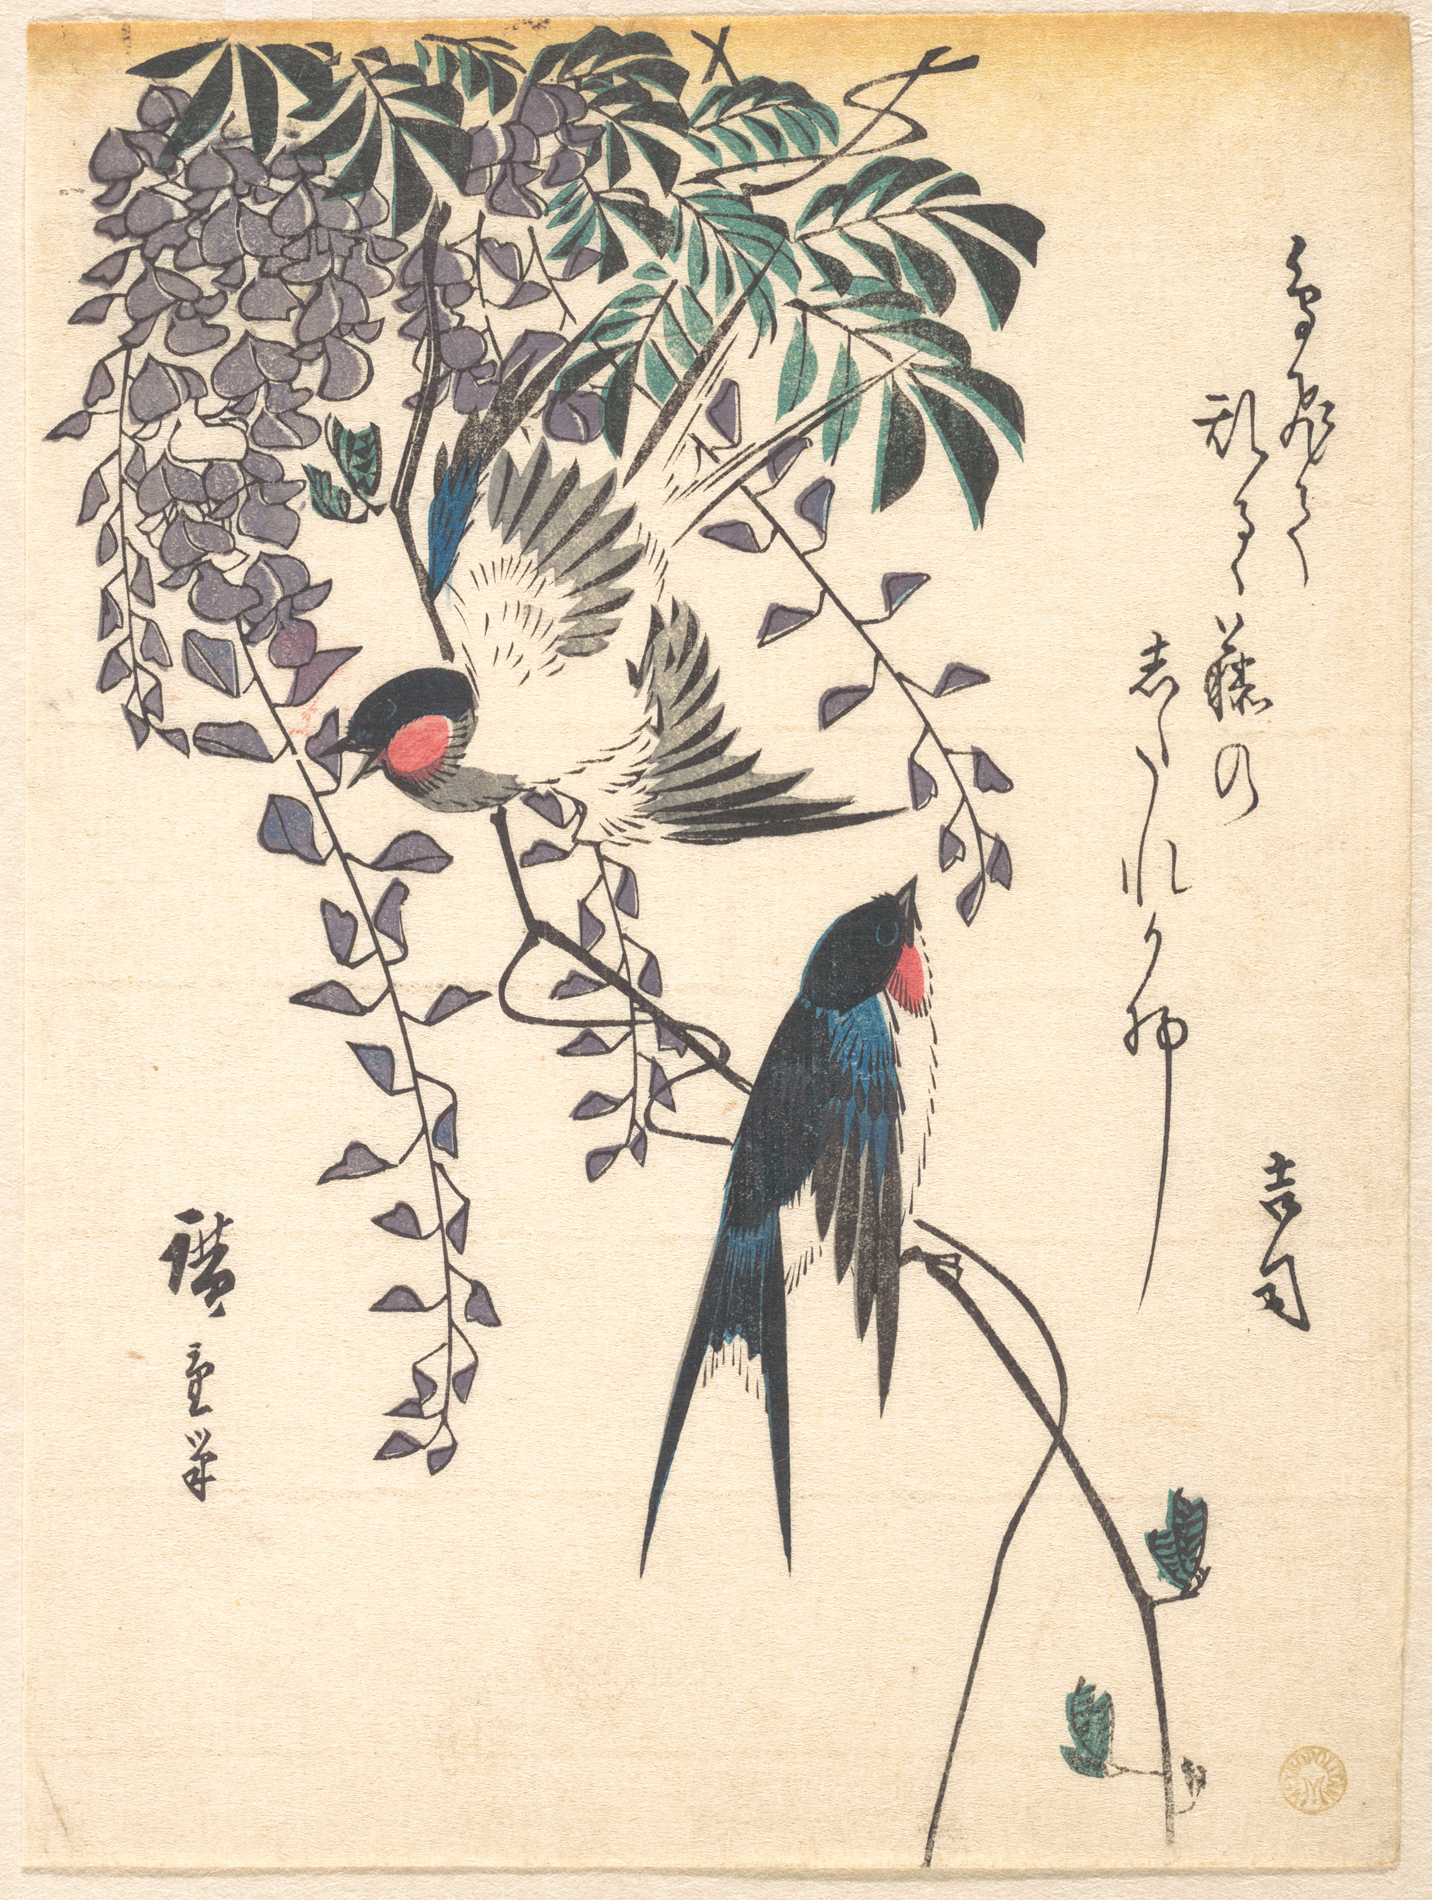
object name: print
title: Swallow and Wisteria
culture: japanese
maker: utagawa hiroshige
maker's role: artist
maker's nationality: japanese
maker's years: 1797-1858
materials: ink, paper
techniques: woodblock print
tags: birds,leaves